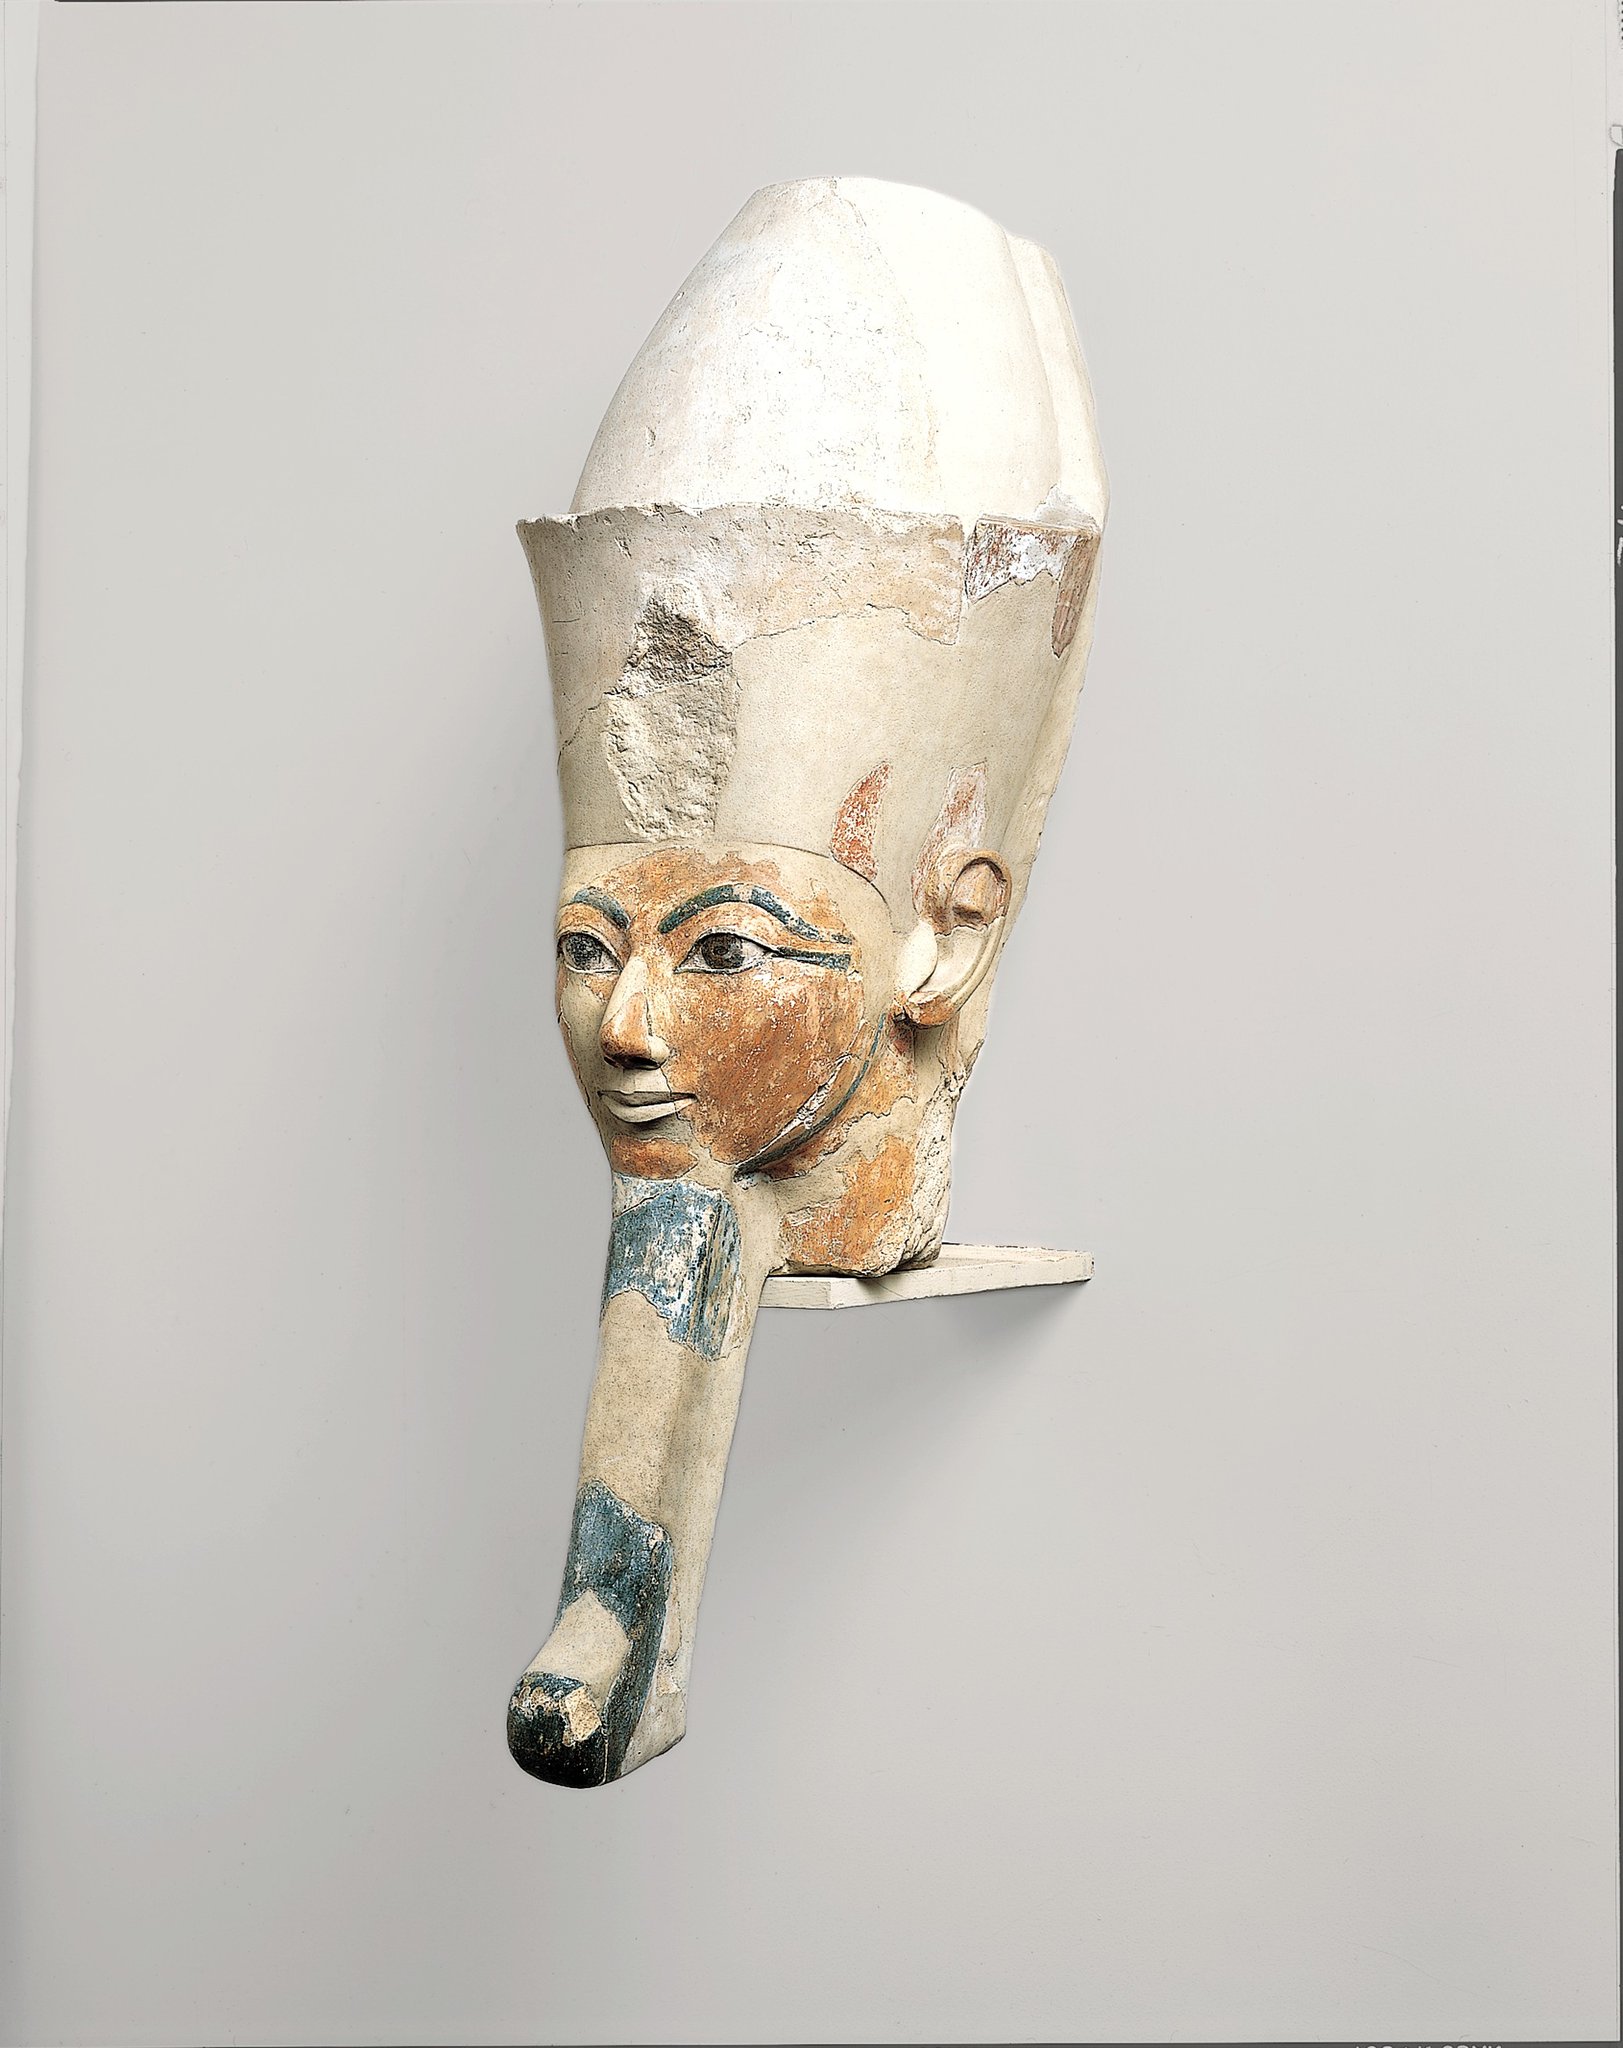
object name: head, hatshepsut, niche, double crown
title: Head from an Osiride Statue of Hatshepsut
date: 1479-1458 BCE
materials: limestone, paint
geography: egypt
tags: heads